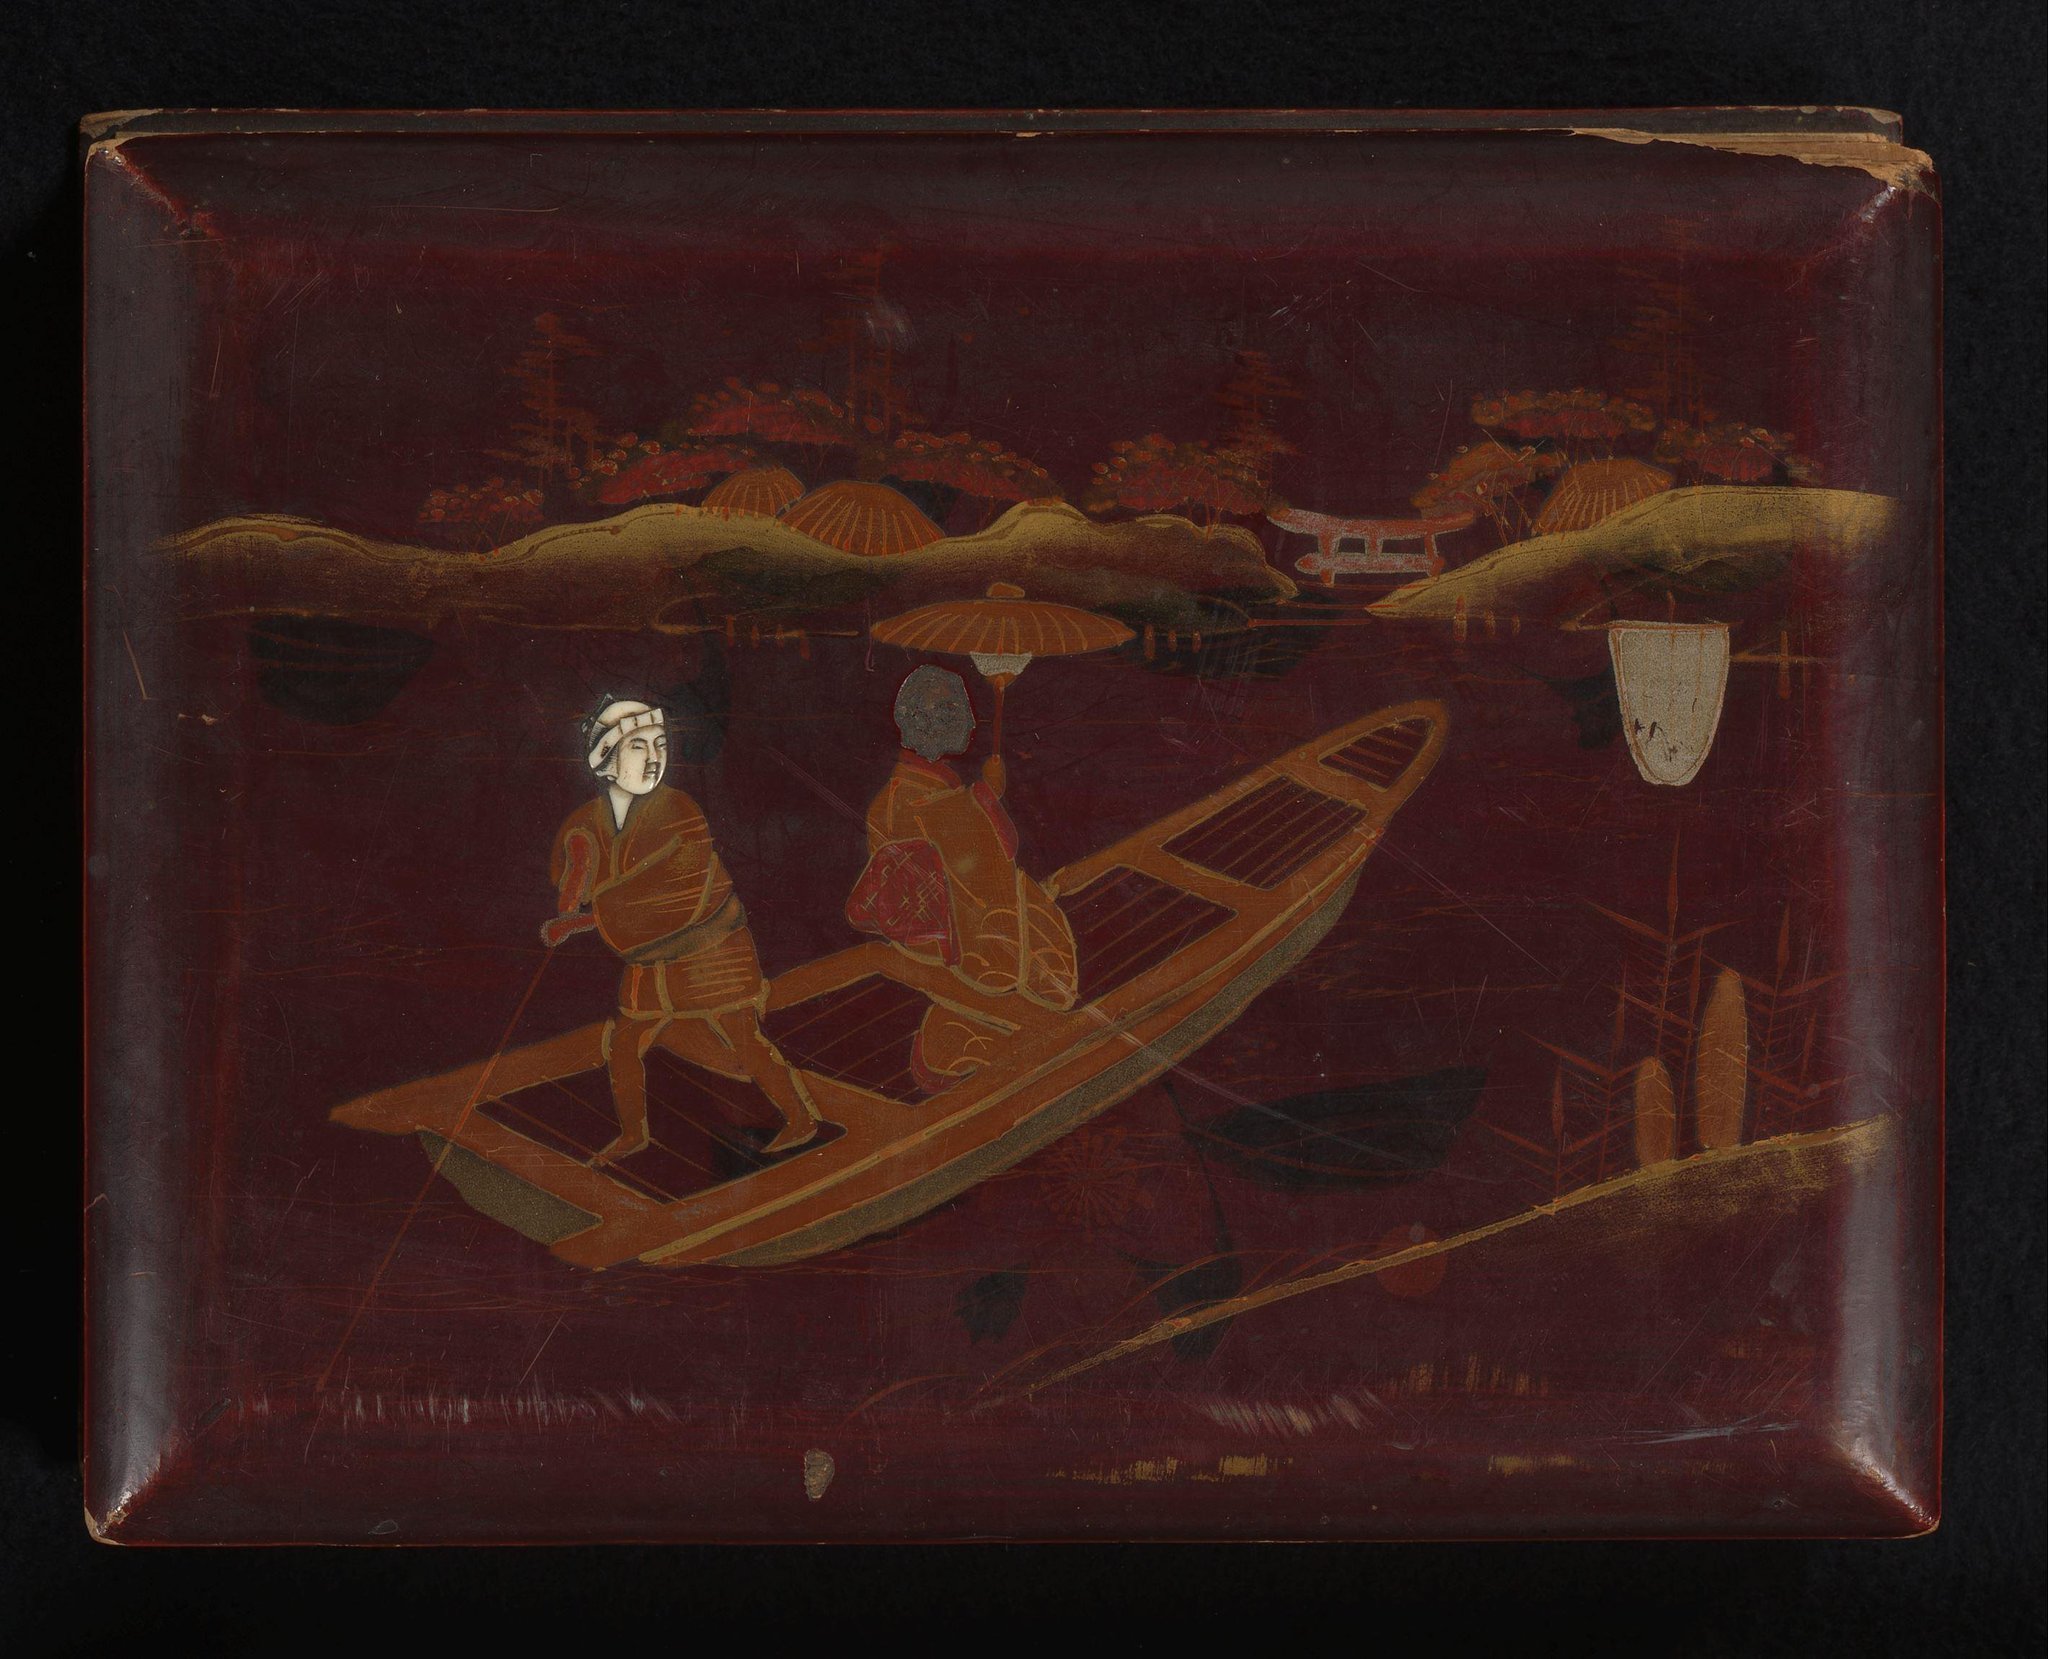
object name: accordion book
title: Japans lakalbum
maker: Anonymous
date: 1851-1900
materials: cardboard, ivory, lacquer, paper, wood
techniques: albumen print, gilding, inlay, lacquer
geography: japan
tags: temple, shrine ~ shinto, adult woman, japan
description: Lakalbum met leporello binding met 50 ingekleurde foto's op 25 bladen. De foto's vertonen straattaferelen en gezichten op tempels uit Japan naast portretten van Japanse vrouwen, mogelijk geisha's.